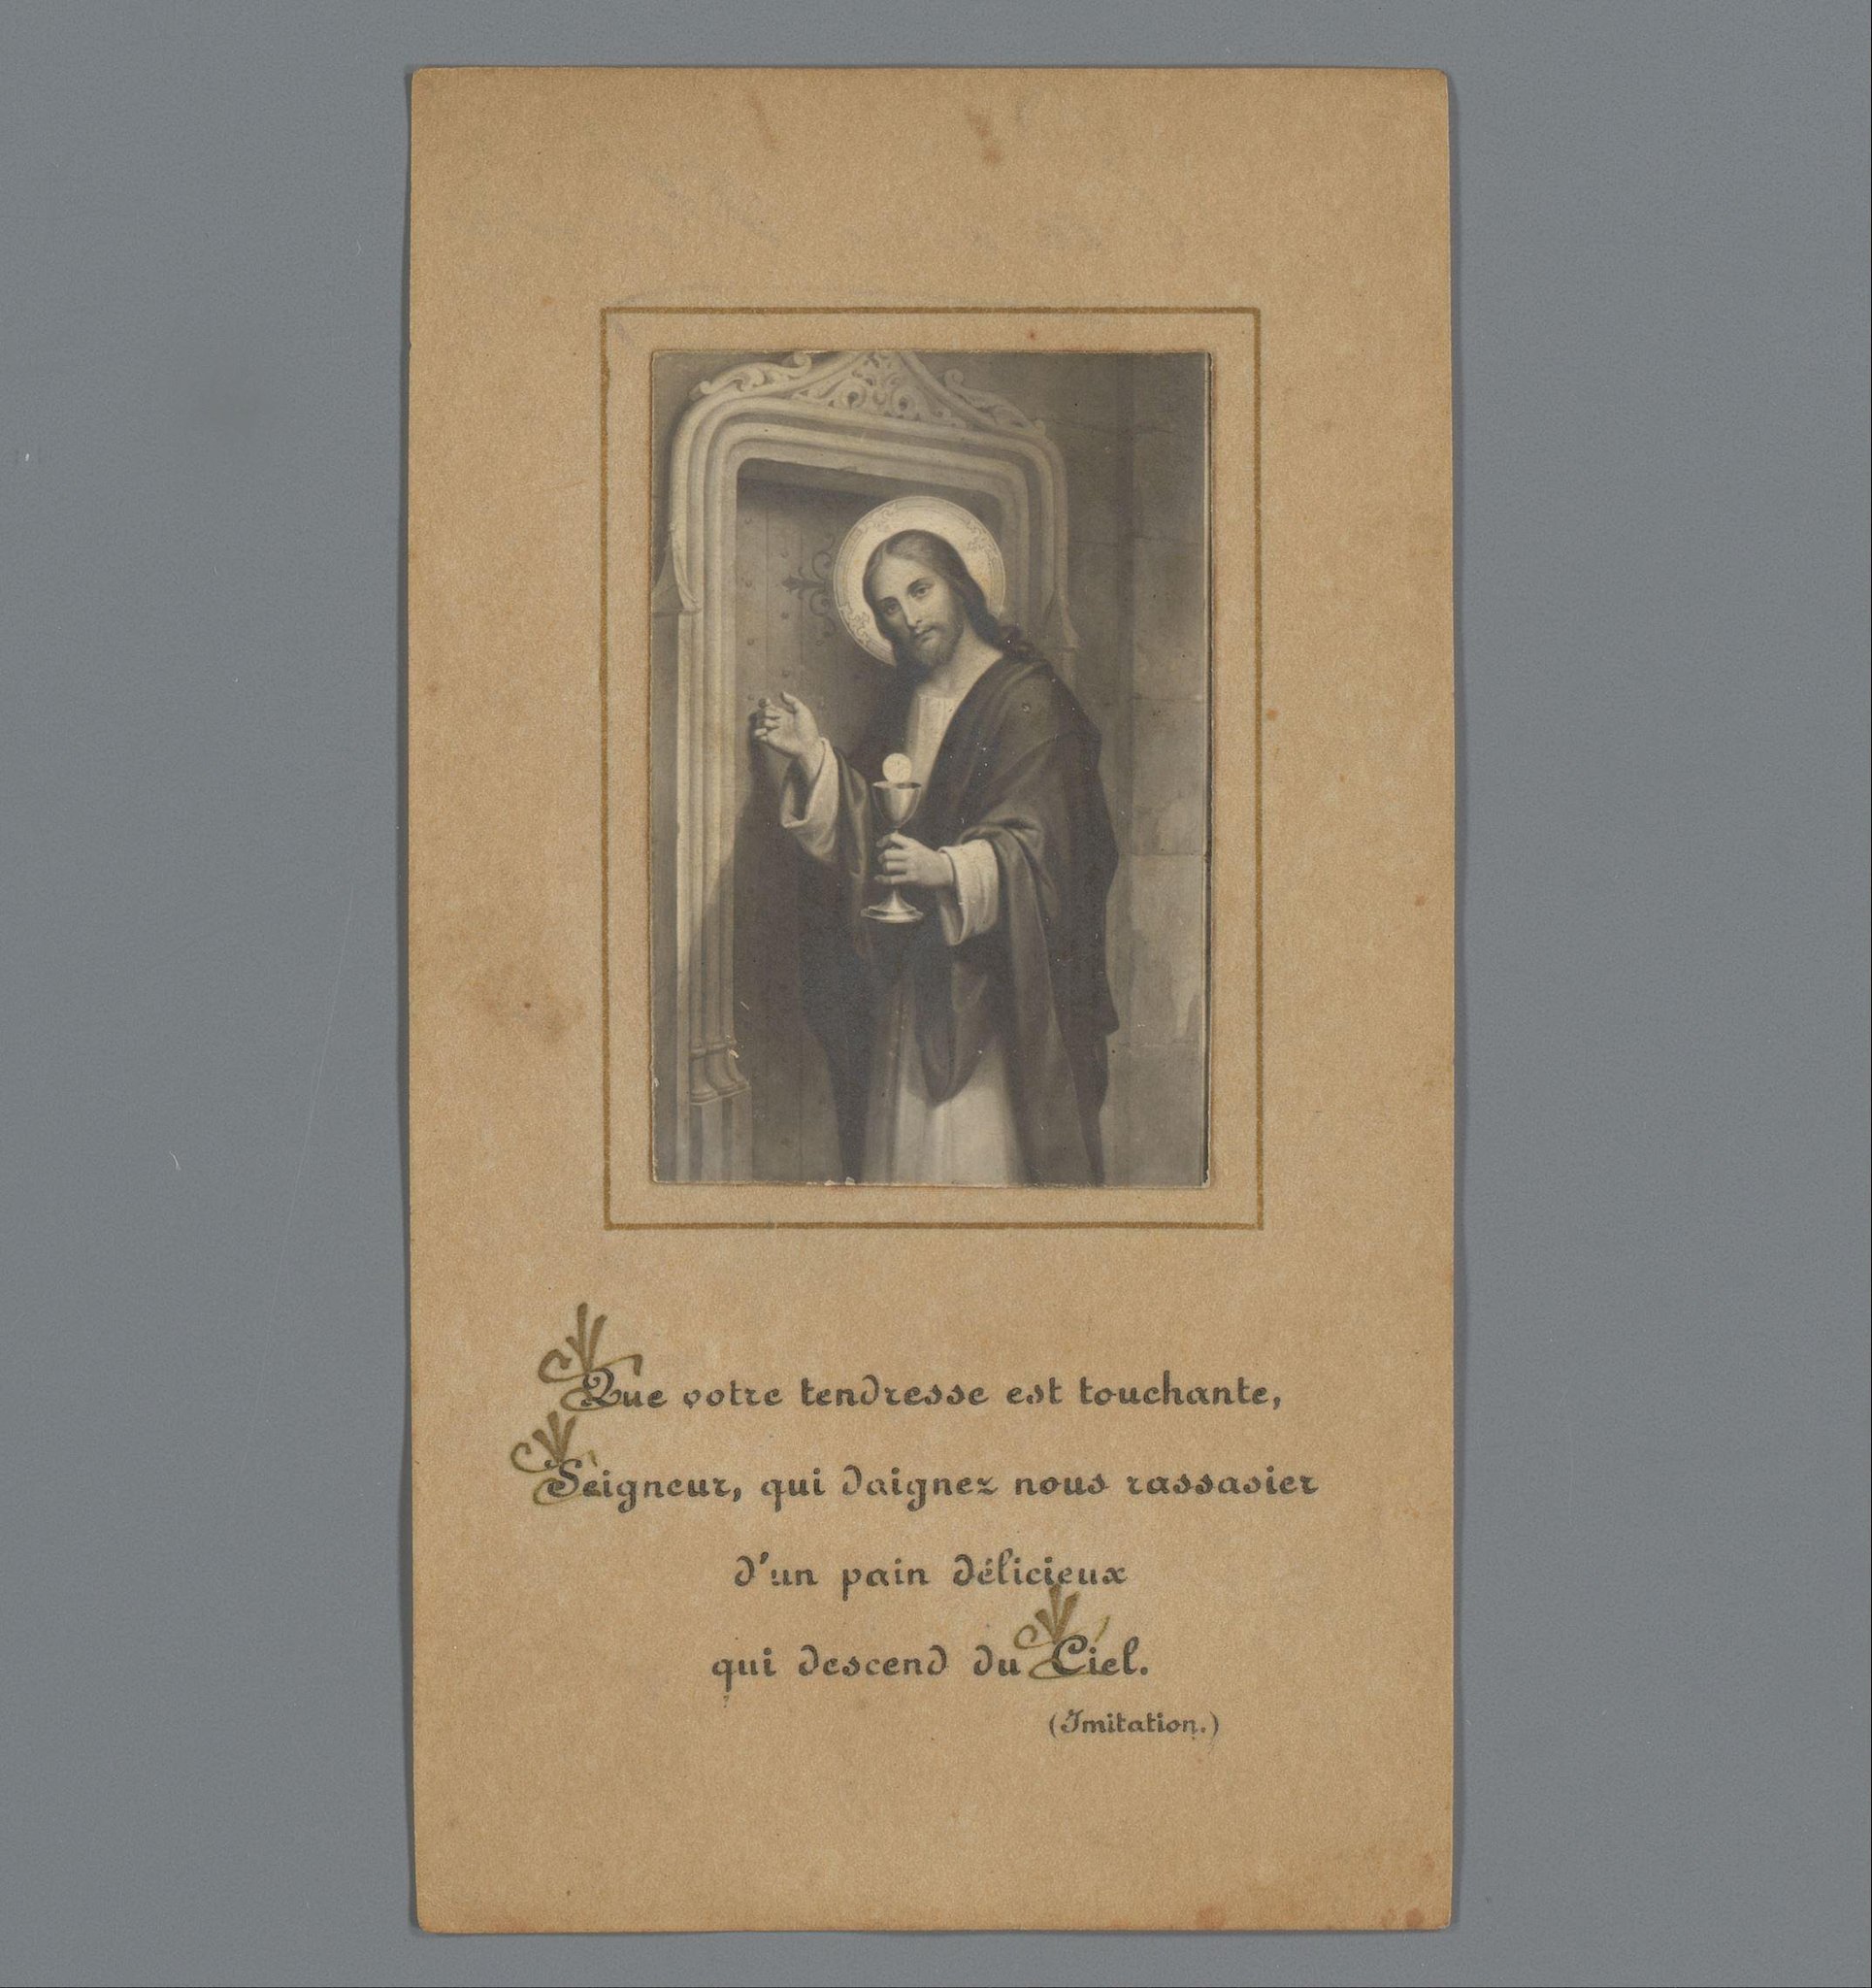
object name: reproduction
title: Fotoreproductie van een schilderij van Christus met kelk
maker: Anonymous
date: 1885-1930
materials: paper, cardboard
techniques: gelatin silver print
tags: christ with chalice, and bread or host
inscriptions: inscription: ‘Van Moeder/ G.’, inscription: ‘Que votre tendresse est touchante,/ Seigneur, qui (...)’